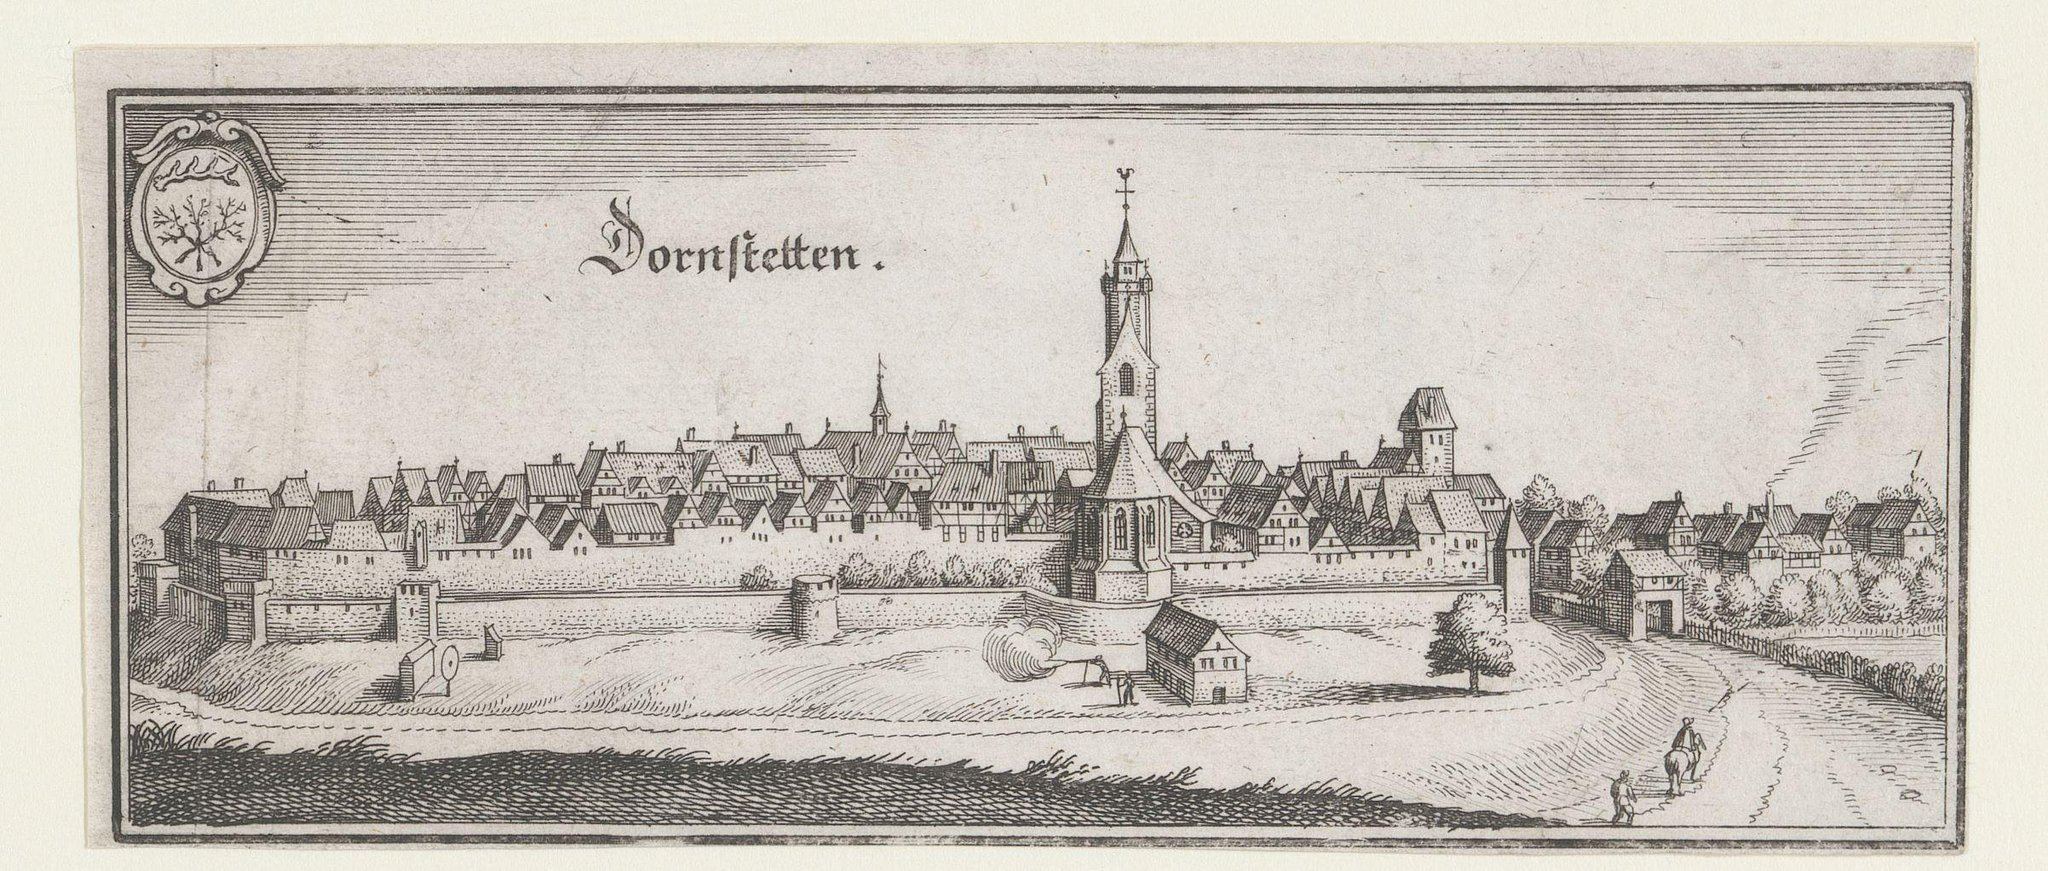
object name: print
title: Dornstetten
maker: matthäus merian (i)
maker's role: print maker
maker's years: 1593-1650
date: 1643-1690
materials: paper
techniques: engraving, etching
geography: frankfurt am main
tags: prospect of city, town panorama, silhouette of city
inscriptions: collector's mark: Lugt 2228